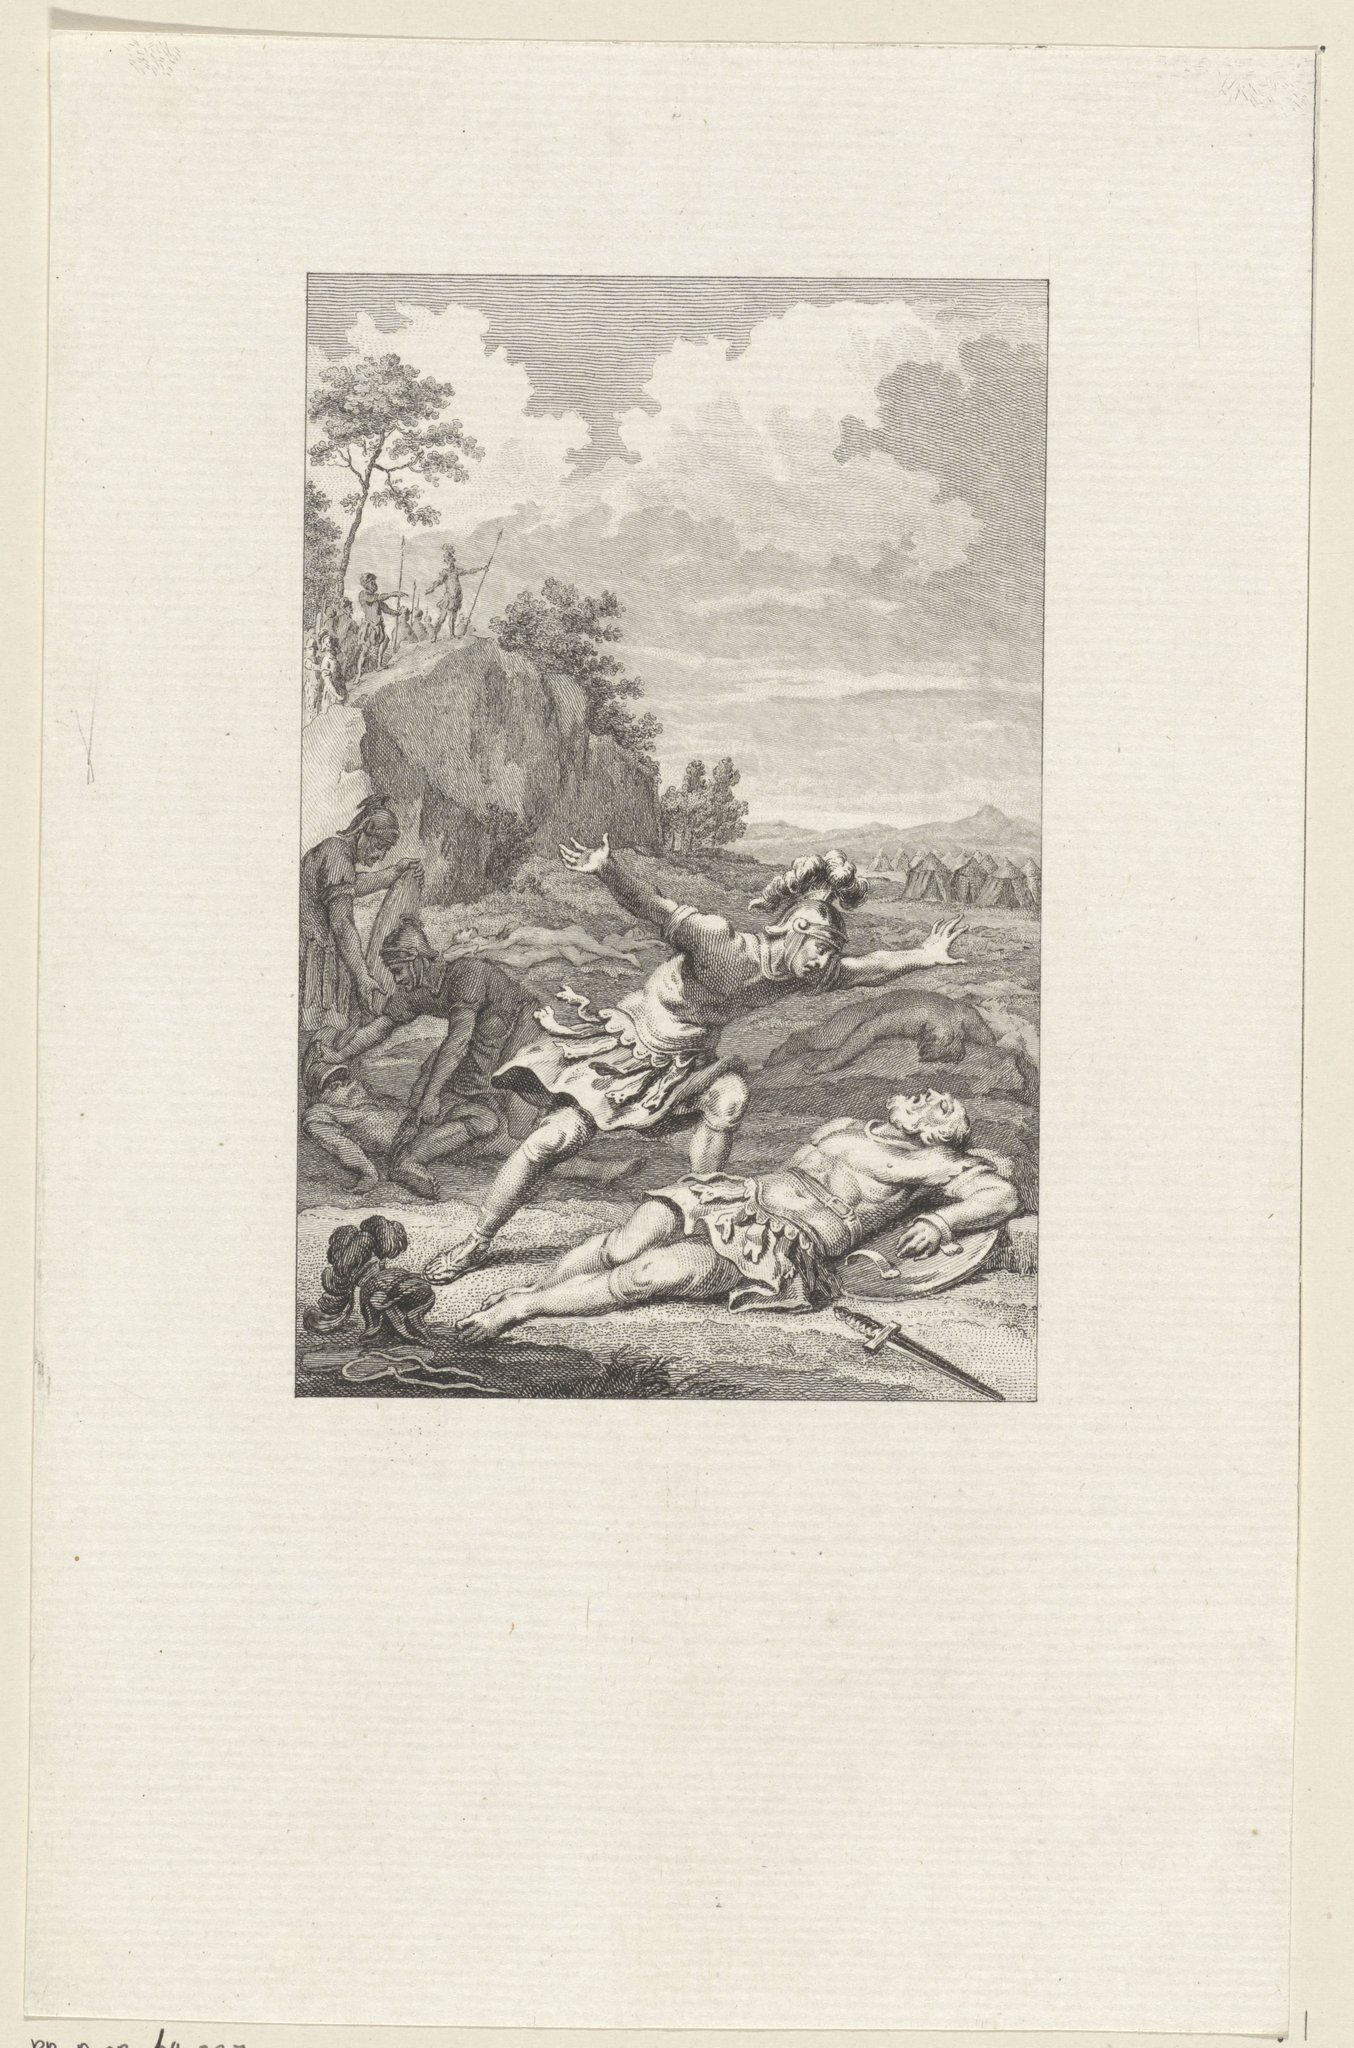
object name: book illustration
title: Julius Mansuetus wordt gedood in een gevecht met zijn zoon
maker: reinier vinkeles (i)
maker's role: draughtsman, print maker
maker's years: 1741-1816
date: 1782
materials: paper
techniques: engraving, etching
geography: amsterdam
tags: (military) camp with tents, duel in place of battle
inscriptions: collector's mark: Lugt 240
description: Latere staat prent gebruikt als boekillustratie in: Martinet, Joannes Florentius. Historie der waereld. Amsterdam: Johannes Allart, 1780-1788. 25 delen. deel III, pl. II.